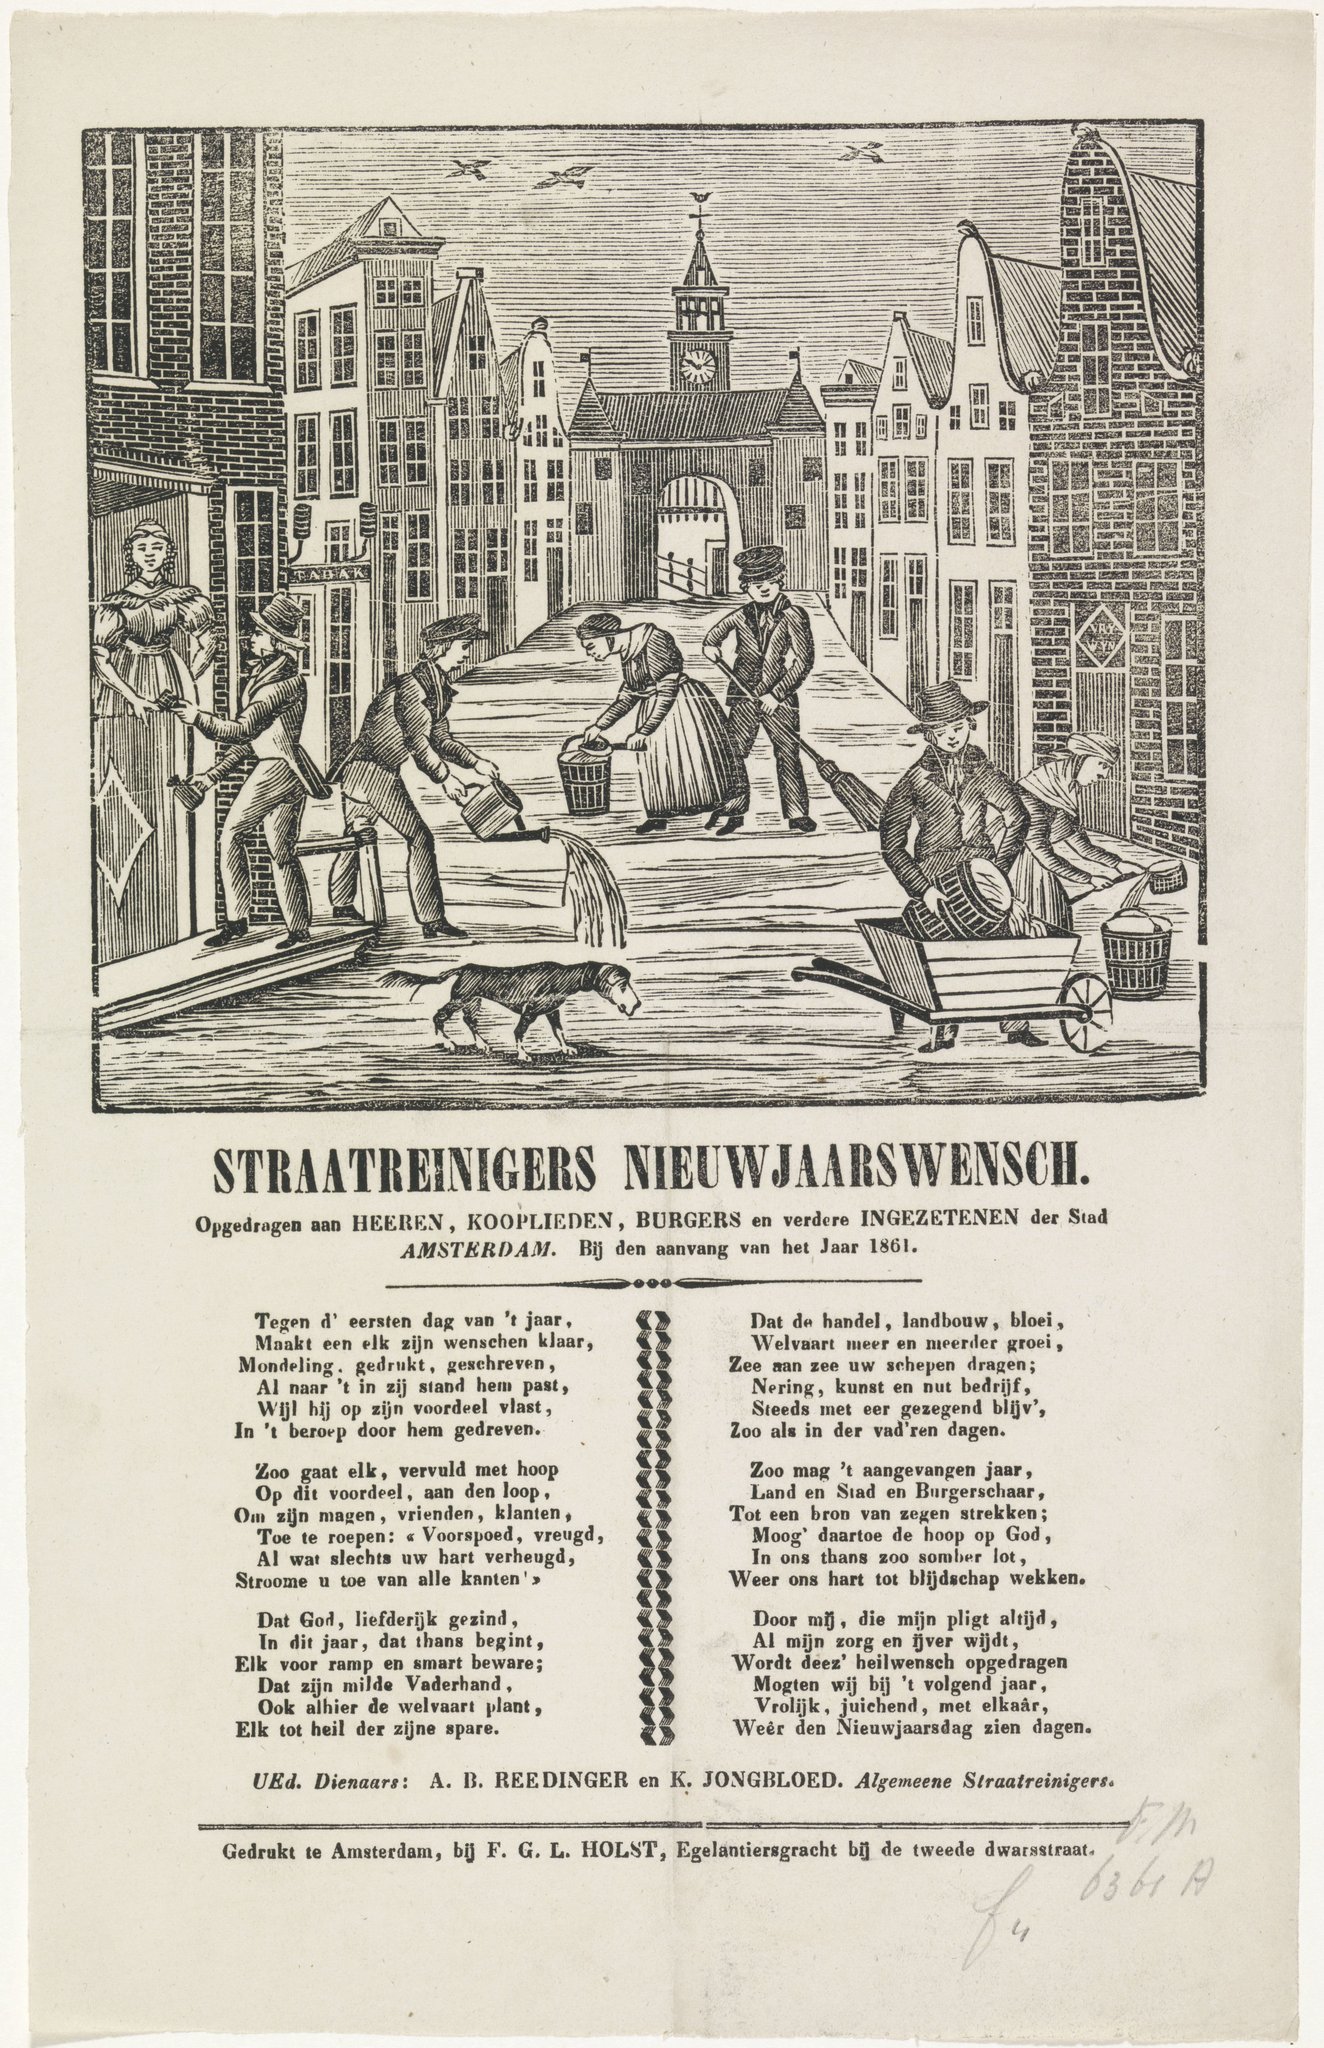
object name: print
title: Straatreinigers Nieuwjaarswensch (...) 1861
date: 1860-1861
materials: paper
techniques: letterpress printing, engraving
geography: amsterdam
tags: street - ii - ideal city, street sweeping, street sweeper, amsterdam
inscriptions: collector's mark: Lugt 2228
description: Nieuwjaarswens van de Amsterdamse straatvegers voor het jaar 1861. Gezicht in de Leidsestraat te Amsterdam met de Leidsepoort, waar meerdere mannelijke en vrouwelijke stratenvegers aan het werk zijn, op de voorgrond haalt een man geld op bij een huis. Met een vers in twee kolommen. Namens de straatvegers: A.B. Reedinger en K. Jongbloed.